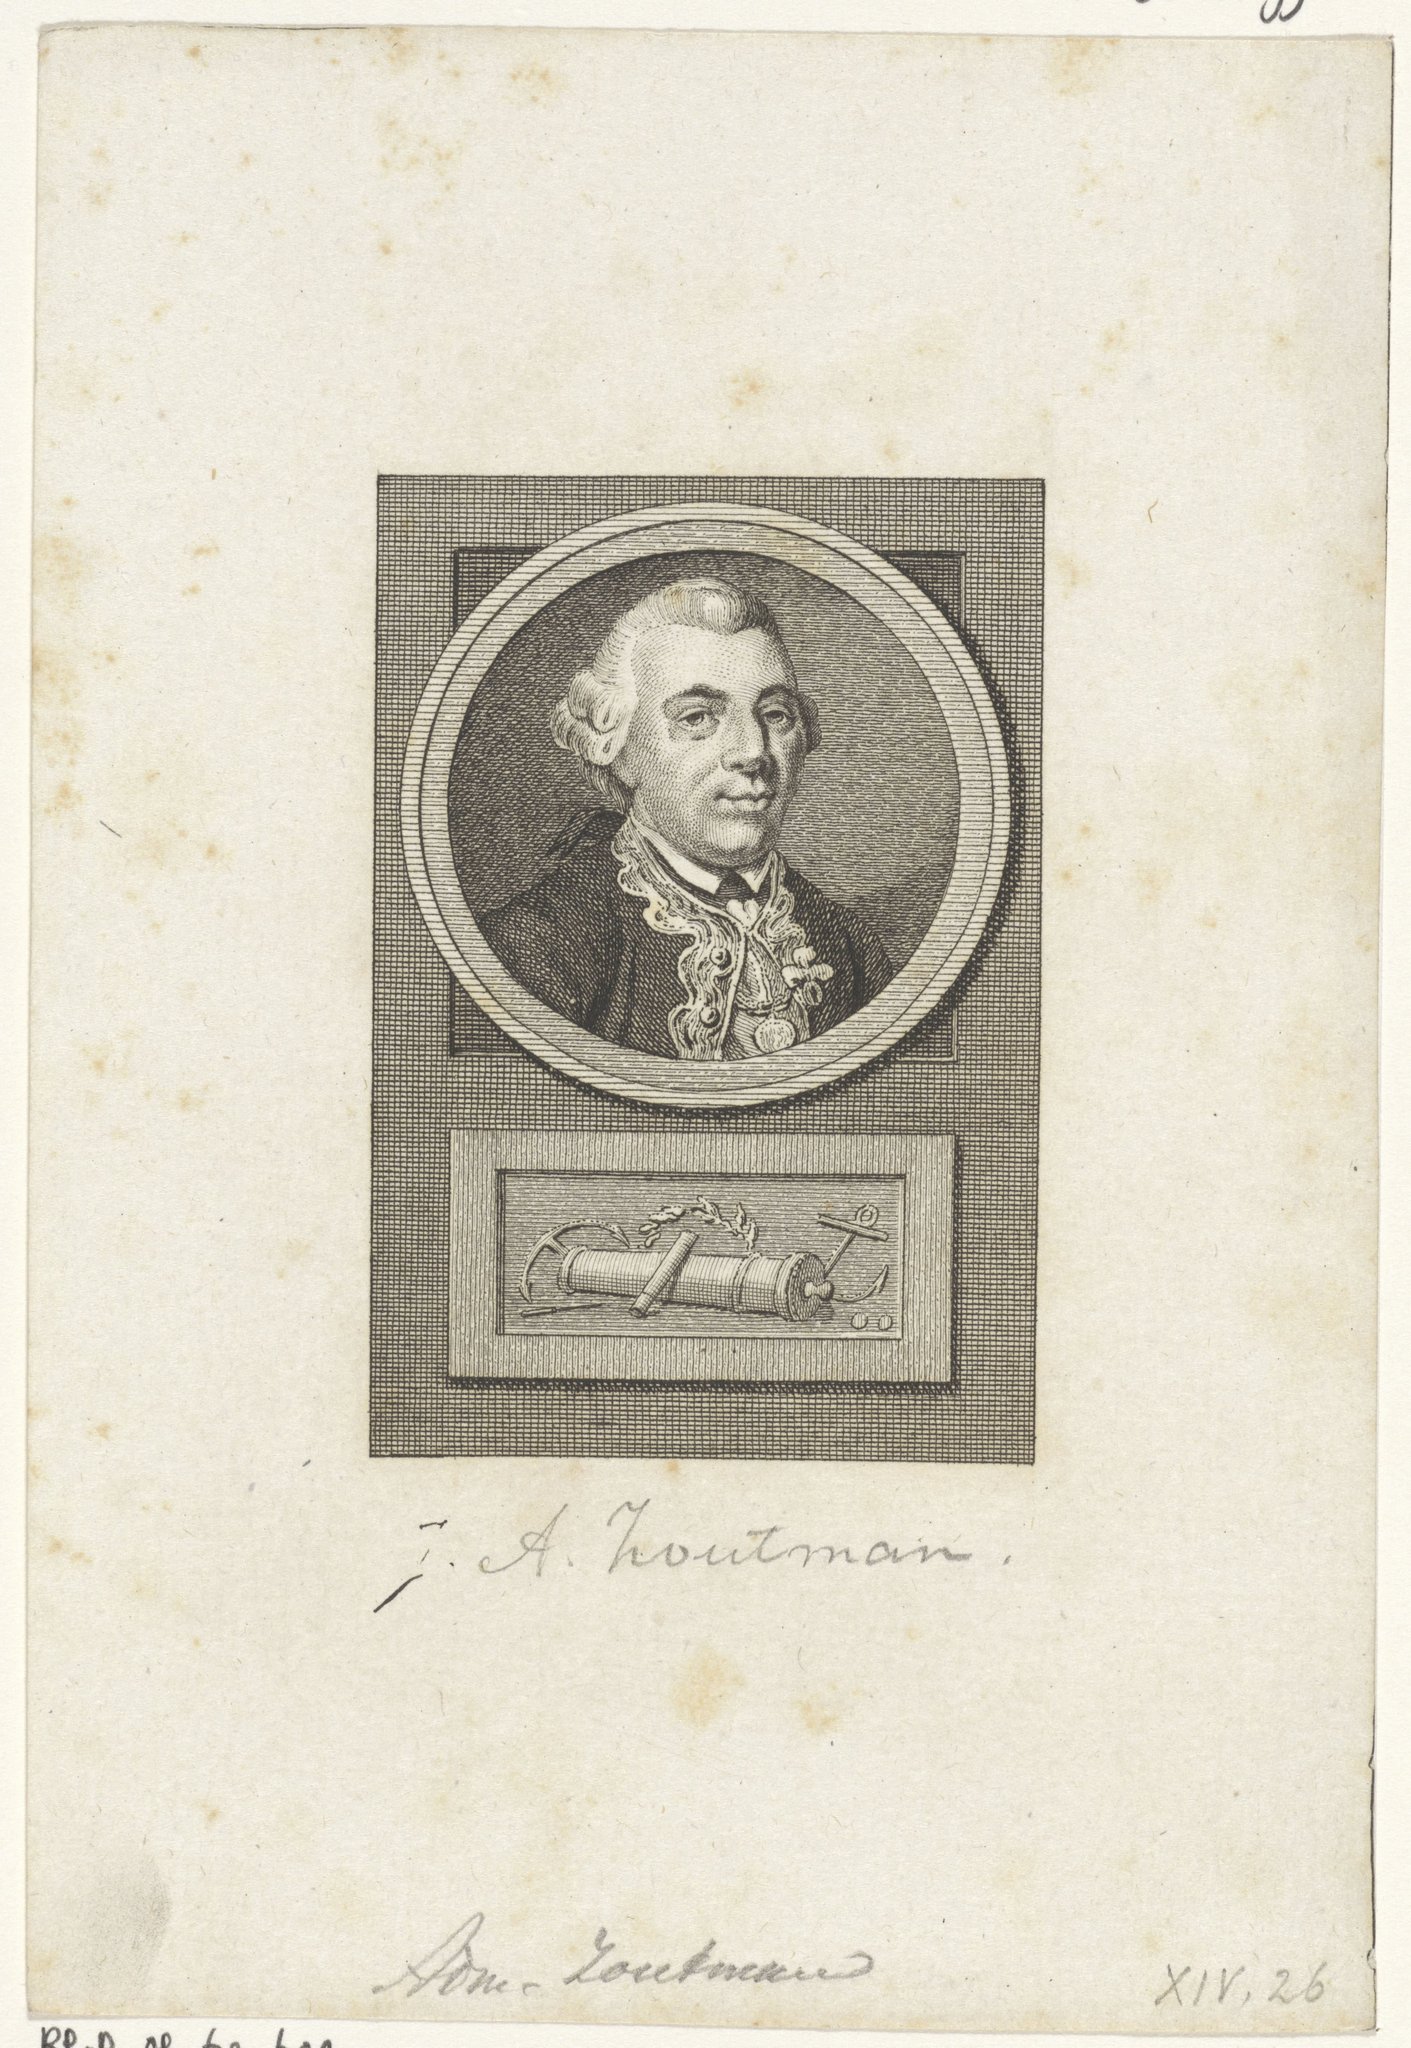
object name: print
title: Portret van Johan Arnold Zoutman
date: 1783-1795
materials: paper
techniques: engraving, etching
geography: amsterdam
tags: the hague, johan arnold zoutman, firearms: cannon, parts of ship's exterior: anchor, baton of general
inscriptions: collector's mark: Lugt 2228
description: Latere staat prent gebruikt in: Fokke, Jan. Geschiedenissen der Vereenigde Nederlanden voor de vaderlandsche jeugd Ie-XXVste deel. Amsterdam: Johannes Allart, 1783-1795. Deel XIV.